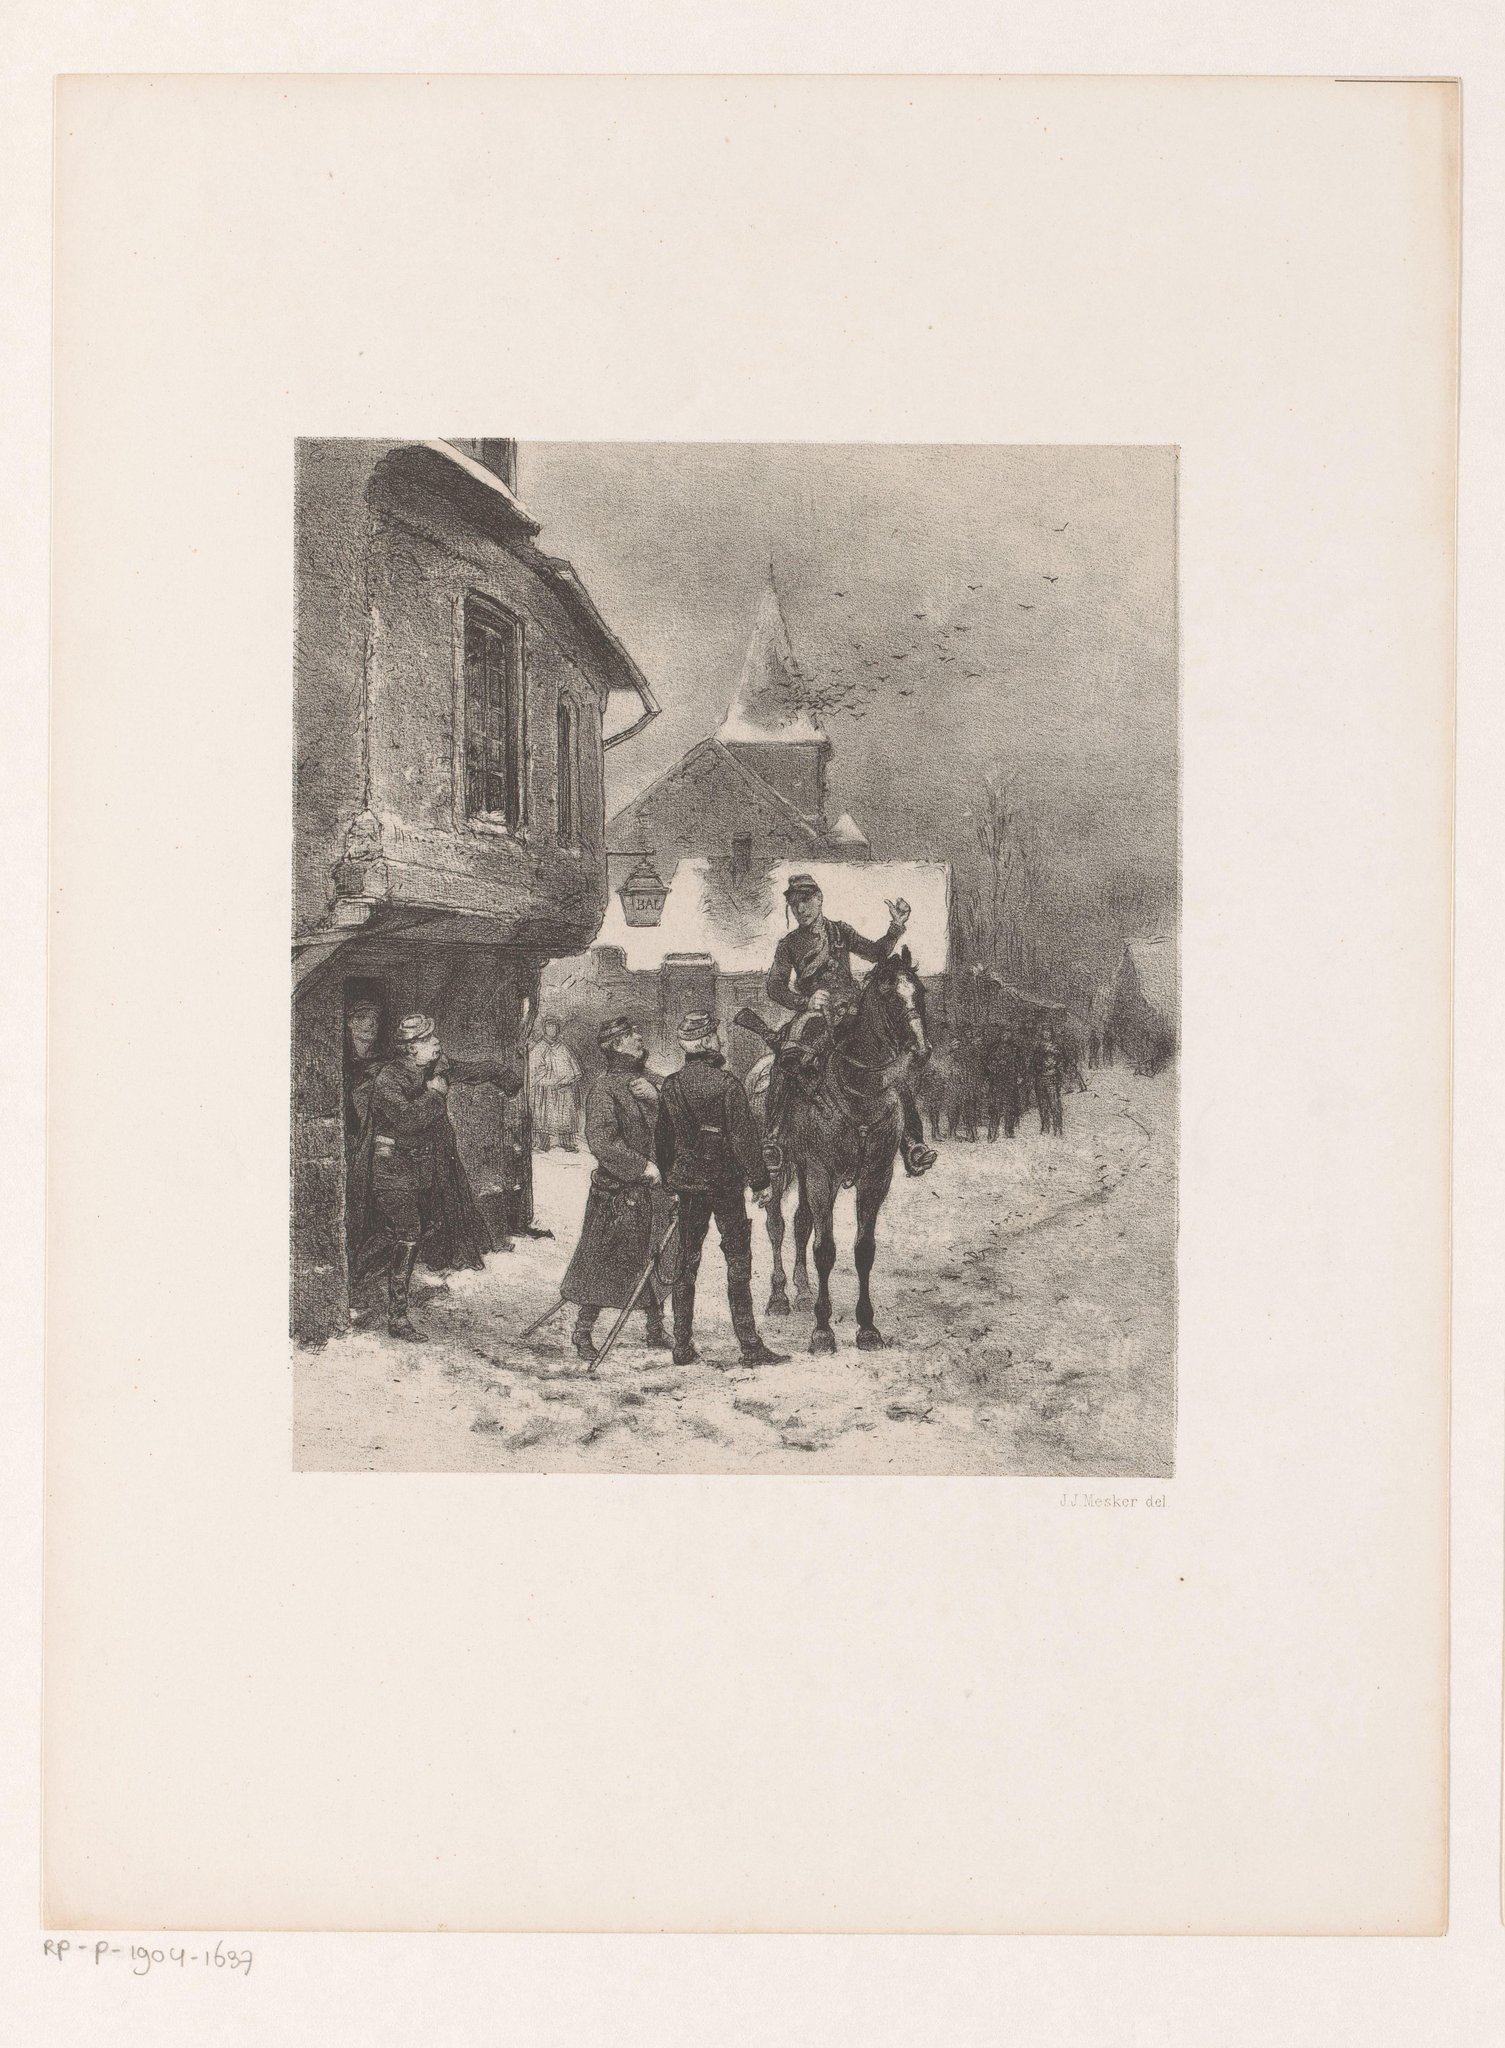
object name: print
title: Militairen bij een herberg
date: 1853-1890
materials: paper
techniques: lithograph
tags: scouting, reconnaissance (military), hotel, hostelry, inn, meeting of soldiers and/or officers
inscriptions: collector's mark: Lugt 2228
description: Een verkenner te paard brengt rapport uit aan een aantal officieren die een herberg uitkomen.